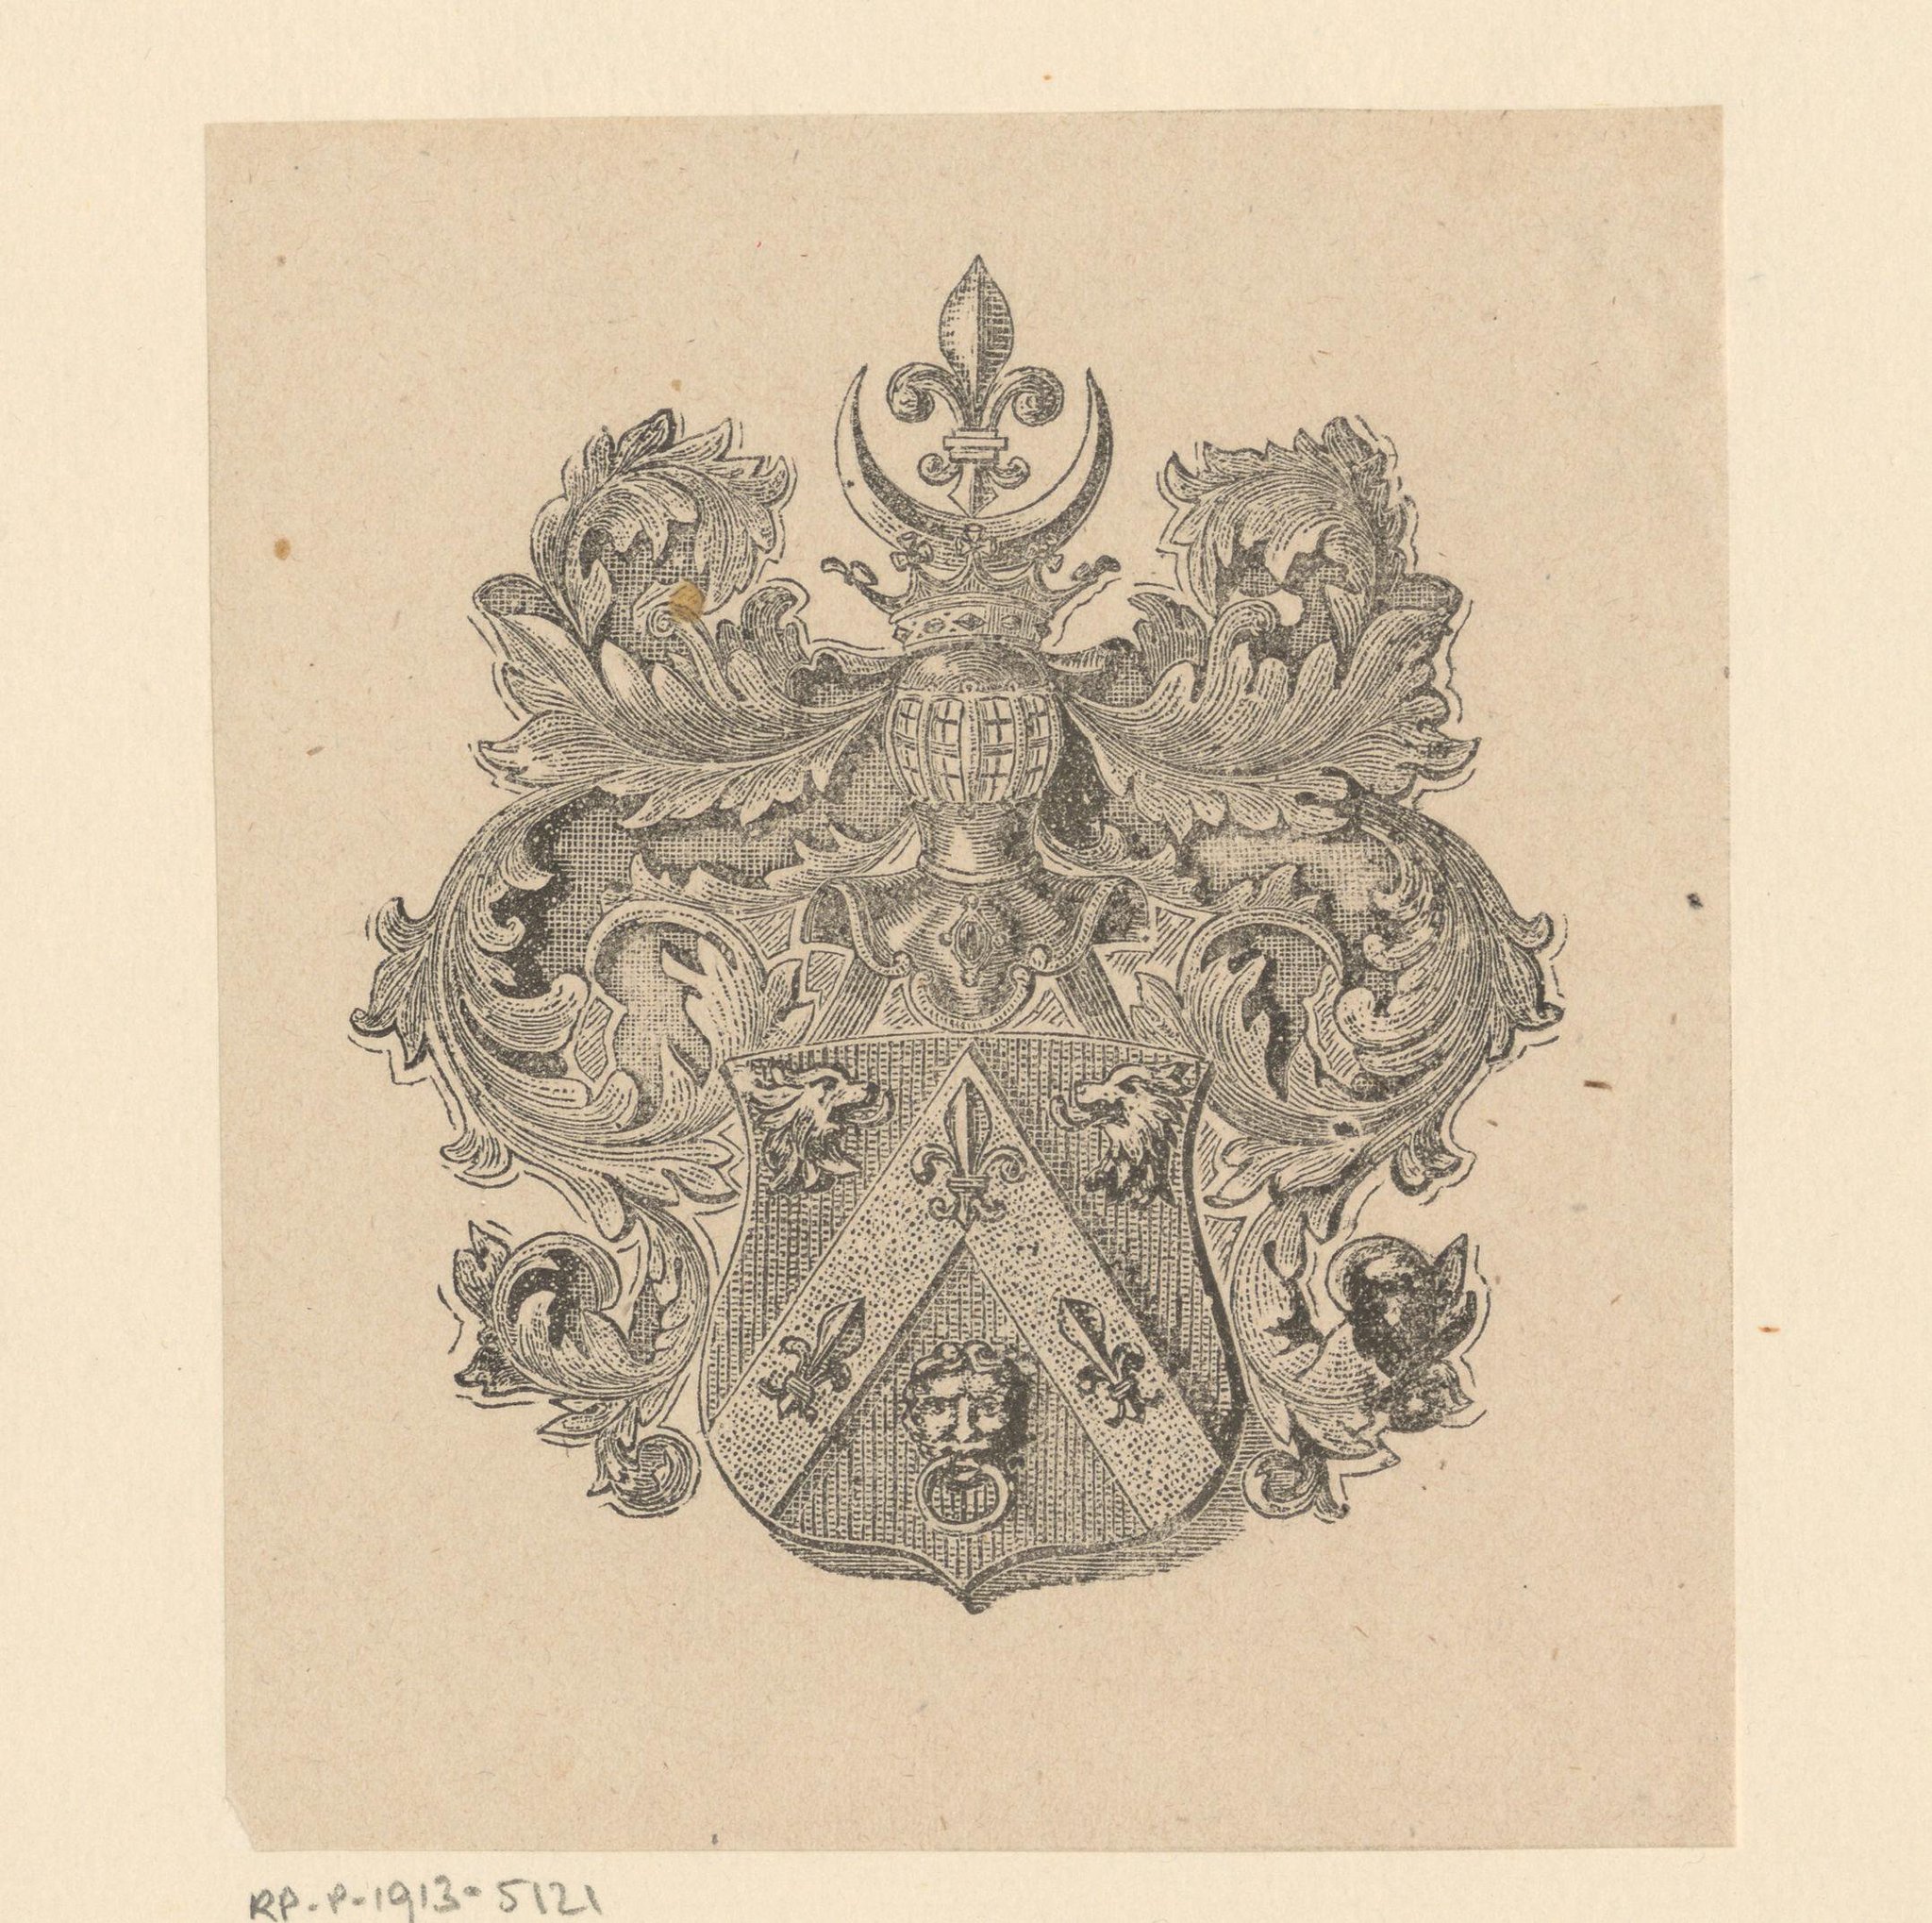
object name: bookplate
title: Ex libris van J. Baart de la Faille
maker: Anonymous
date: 1750-1899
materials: paper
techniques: woodcut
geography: netherlands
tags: the hague, physicist, fleur-de-lis ~ ornament, armorial bearing, heraldry, dog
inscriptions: collector's mark: Lugt 2233, collector's mark: Lugt 2760